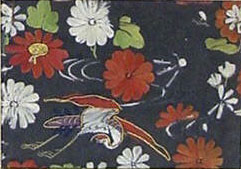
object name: piece from a kosode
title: Piece from a Kosode with Crane and Chrysanthemums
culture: japanese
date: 1615-1868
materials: metal thread, silk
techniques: damask, embroidery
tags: cranes,flowers